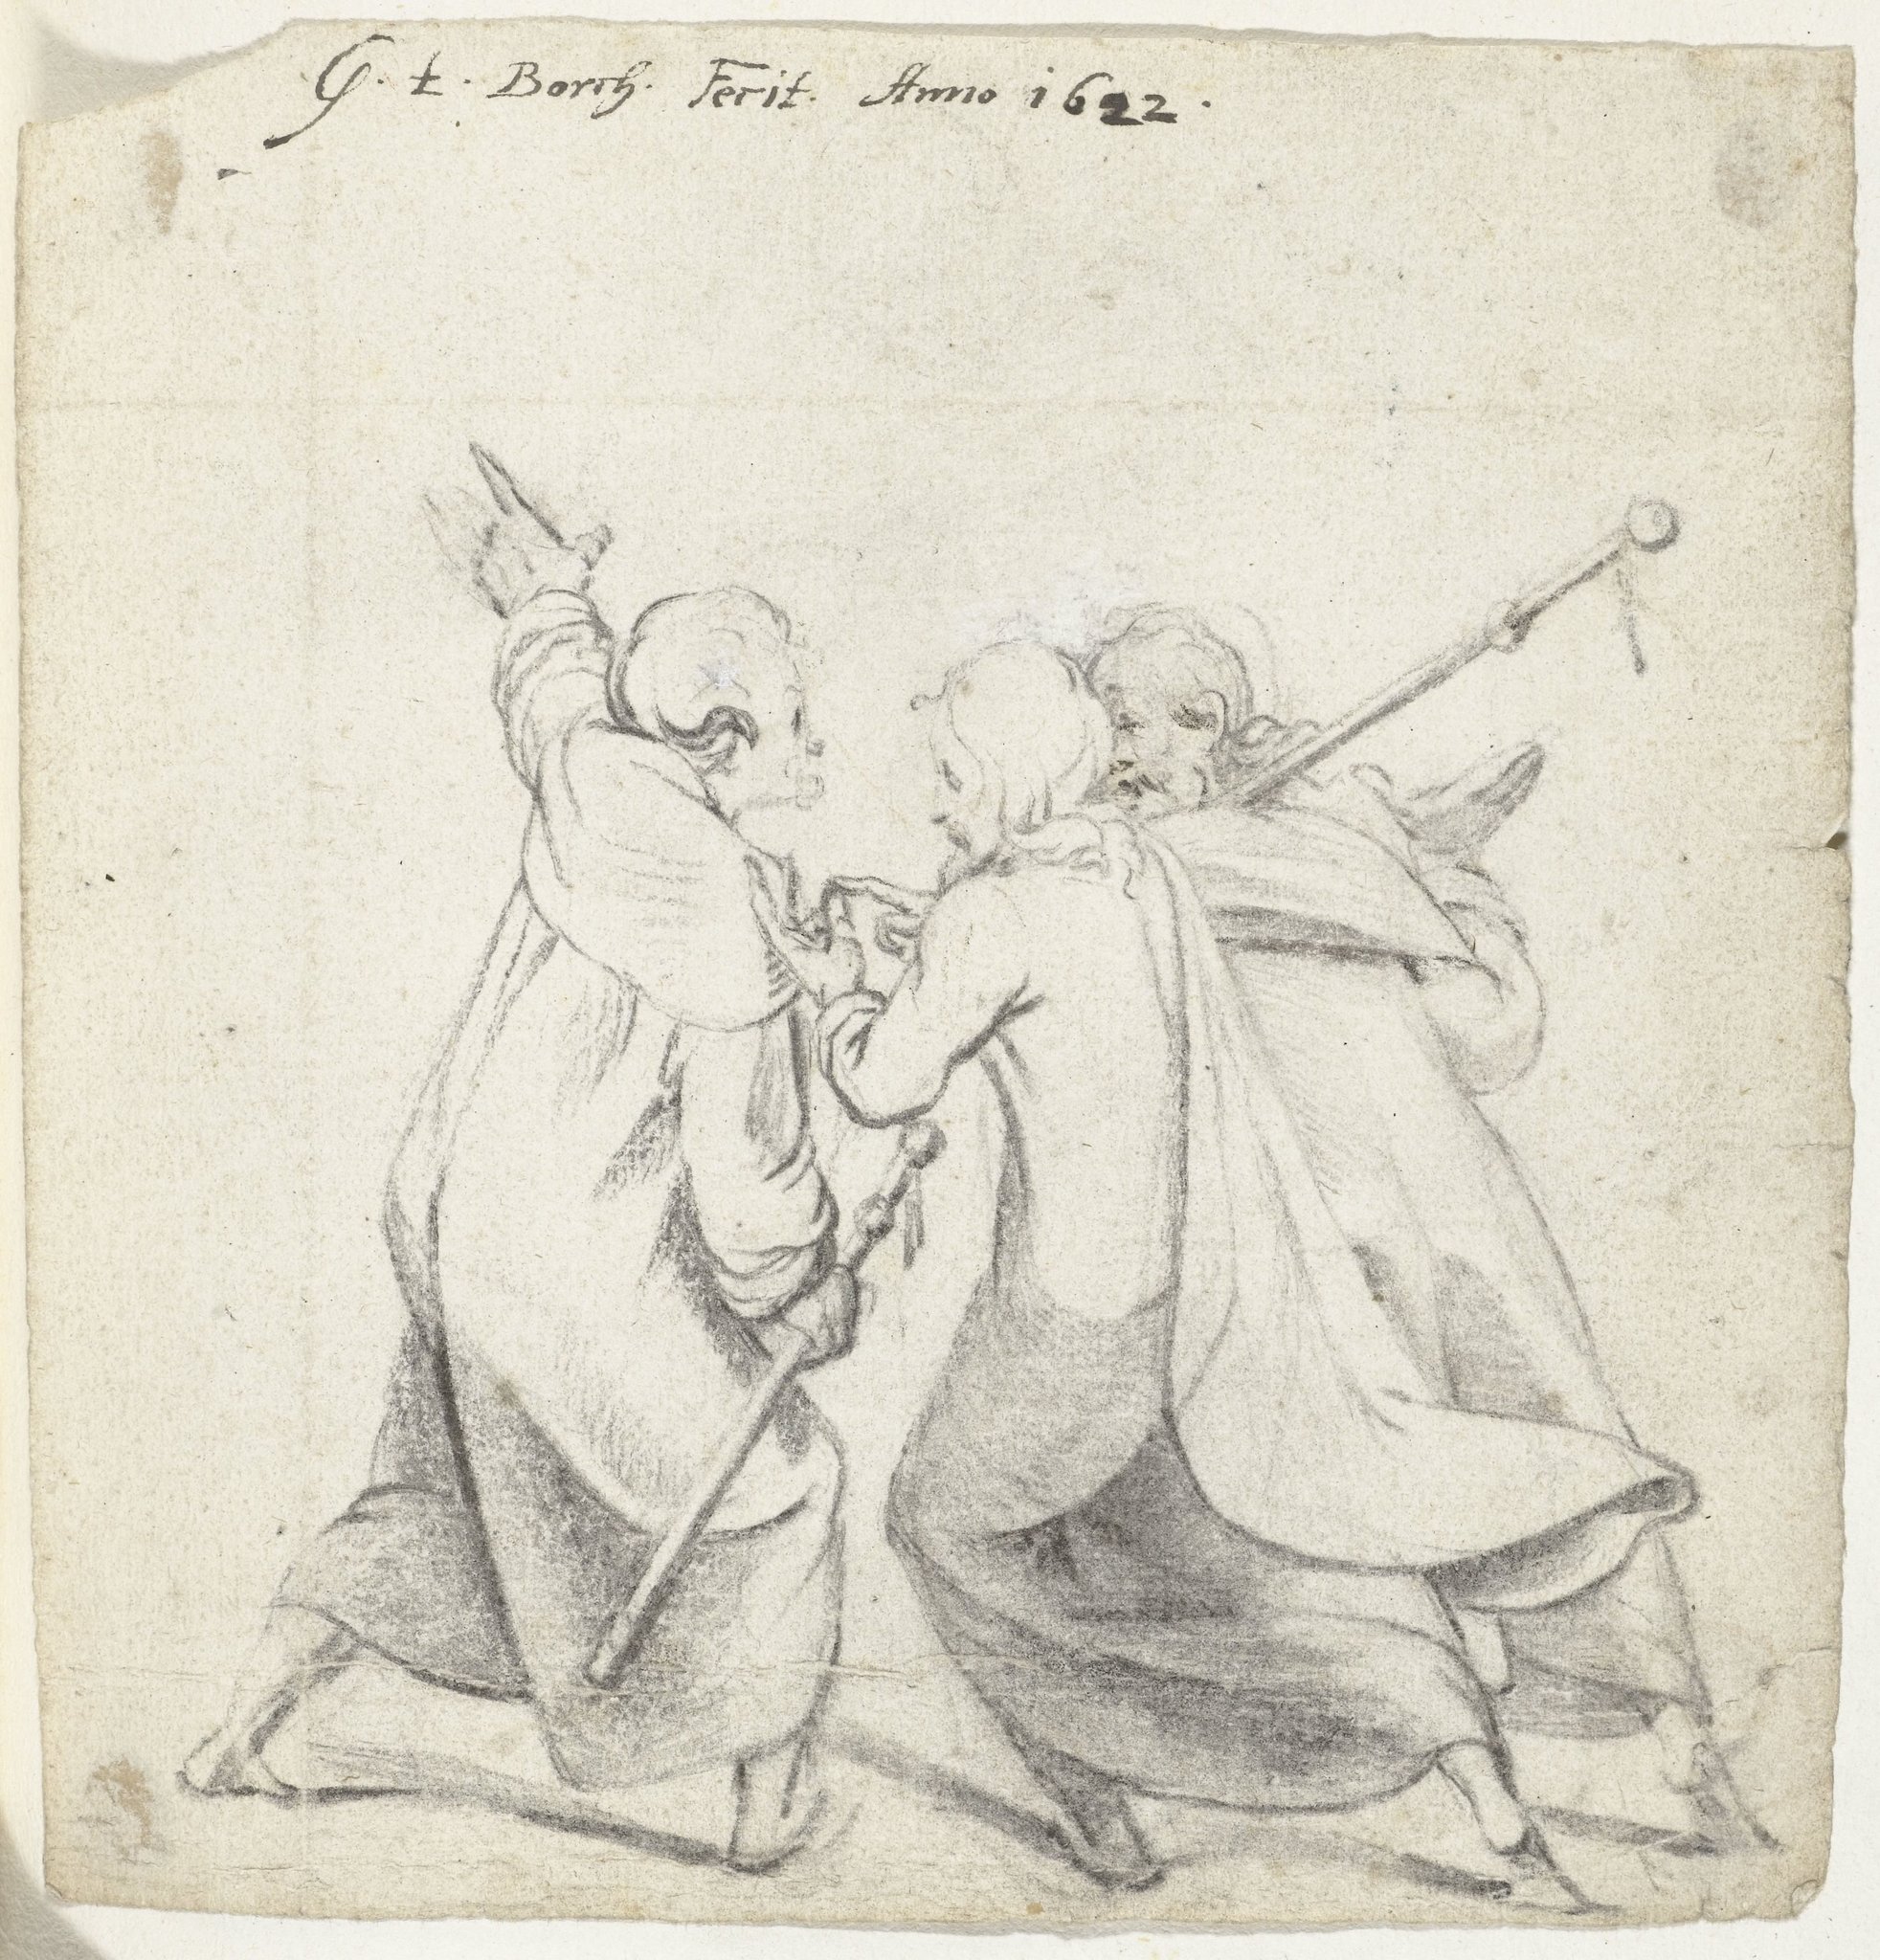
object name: drawing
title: Op weg naar Emmaüs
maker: gerard ter borch (i)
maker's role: draughtsman, print maker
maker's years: 1584-1662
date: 1622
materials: chalk, paint, paper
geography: zwolle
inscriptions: annotation: ‘G.T.Borch. Fecit. Anno 1622’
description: Tekening naast een andere tekening in het Familie-plakboek geplakt.